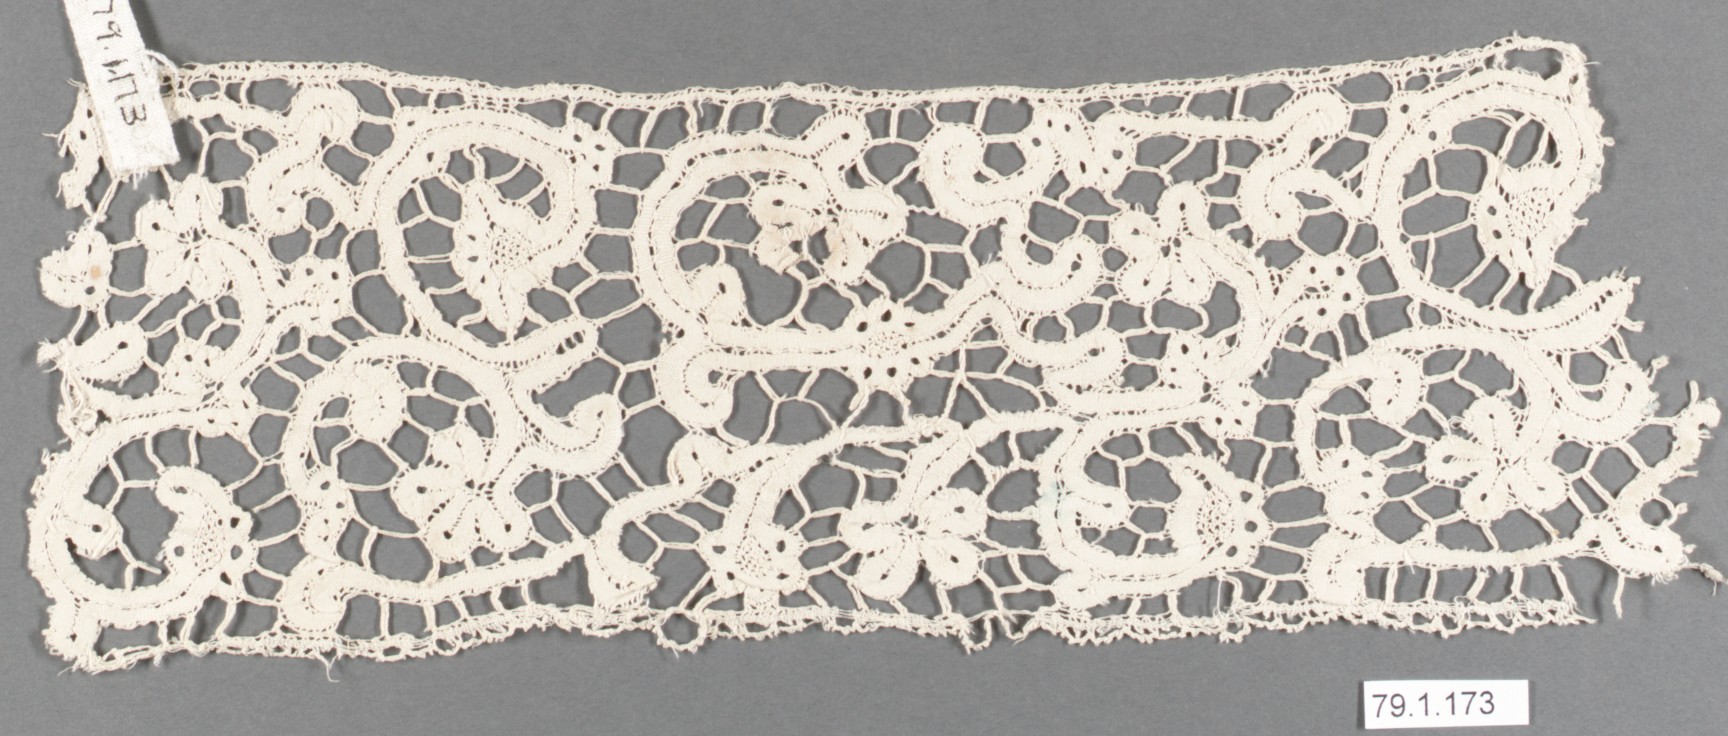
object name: fragment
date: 1667-1700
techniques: lace